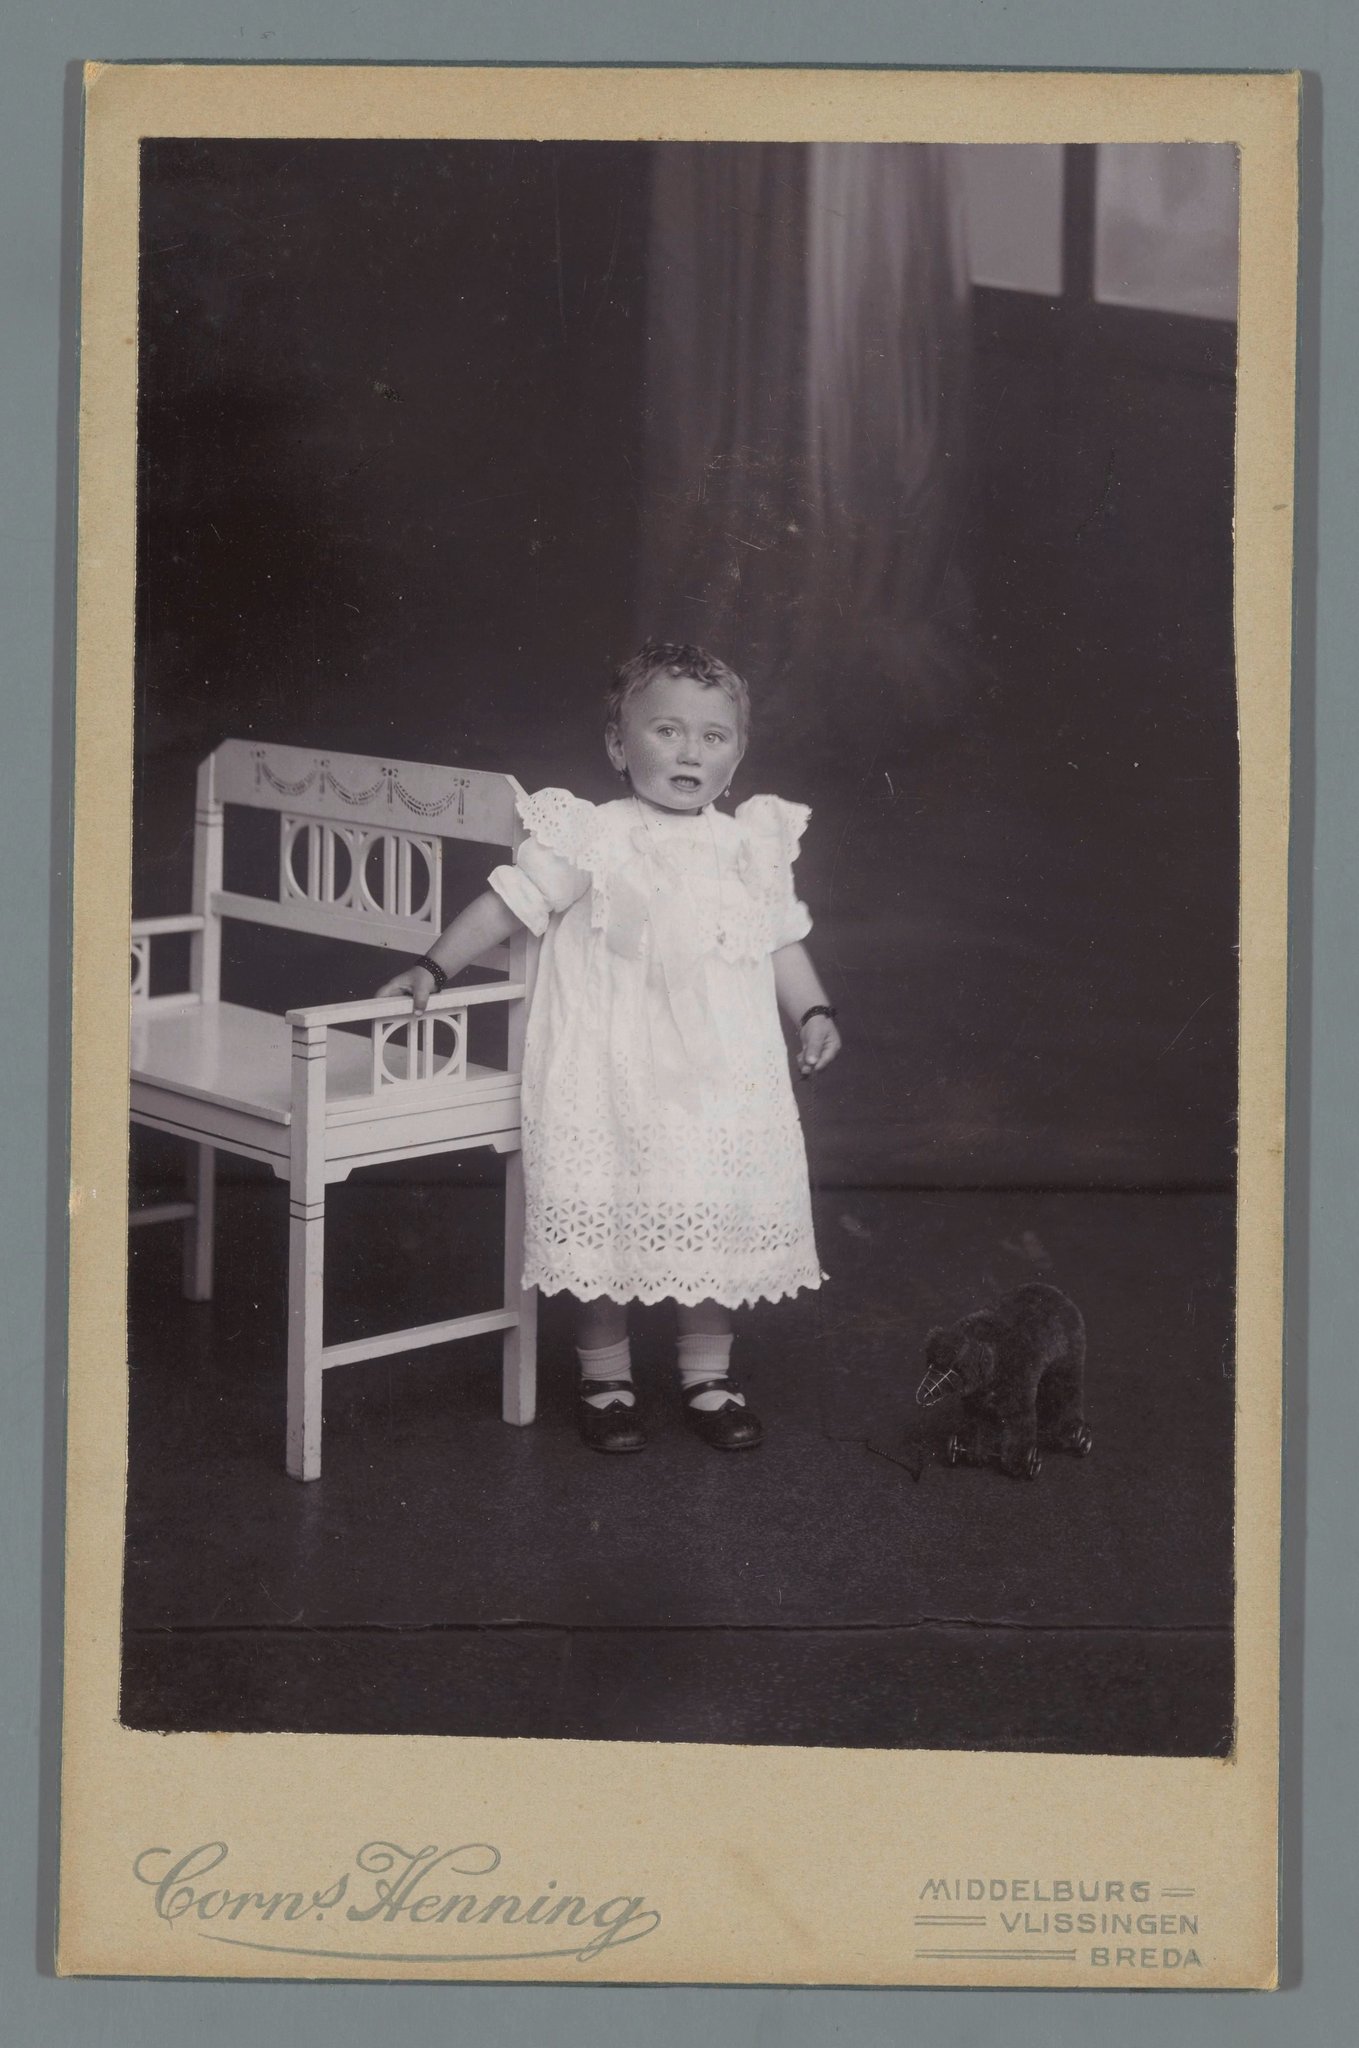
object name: cabinet photograph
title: Portret van een kind met een speelgoeddier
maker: cornelis henning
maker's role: fotograaf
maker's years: 1874-1944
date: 1891-1944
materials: cardboard, photographic support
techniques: collodion silver print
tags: child, (playing with) dolls, toy animals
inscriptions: name: ‘Photographisch Ateliers Corns. Henning Middelburg Markt C14. Vlissingen Badhuisstraat no. 63. Breda Van Coothplein 12. (...)’